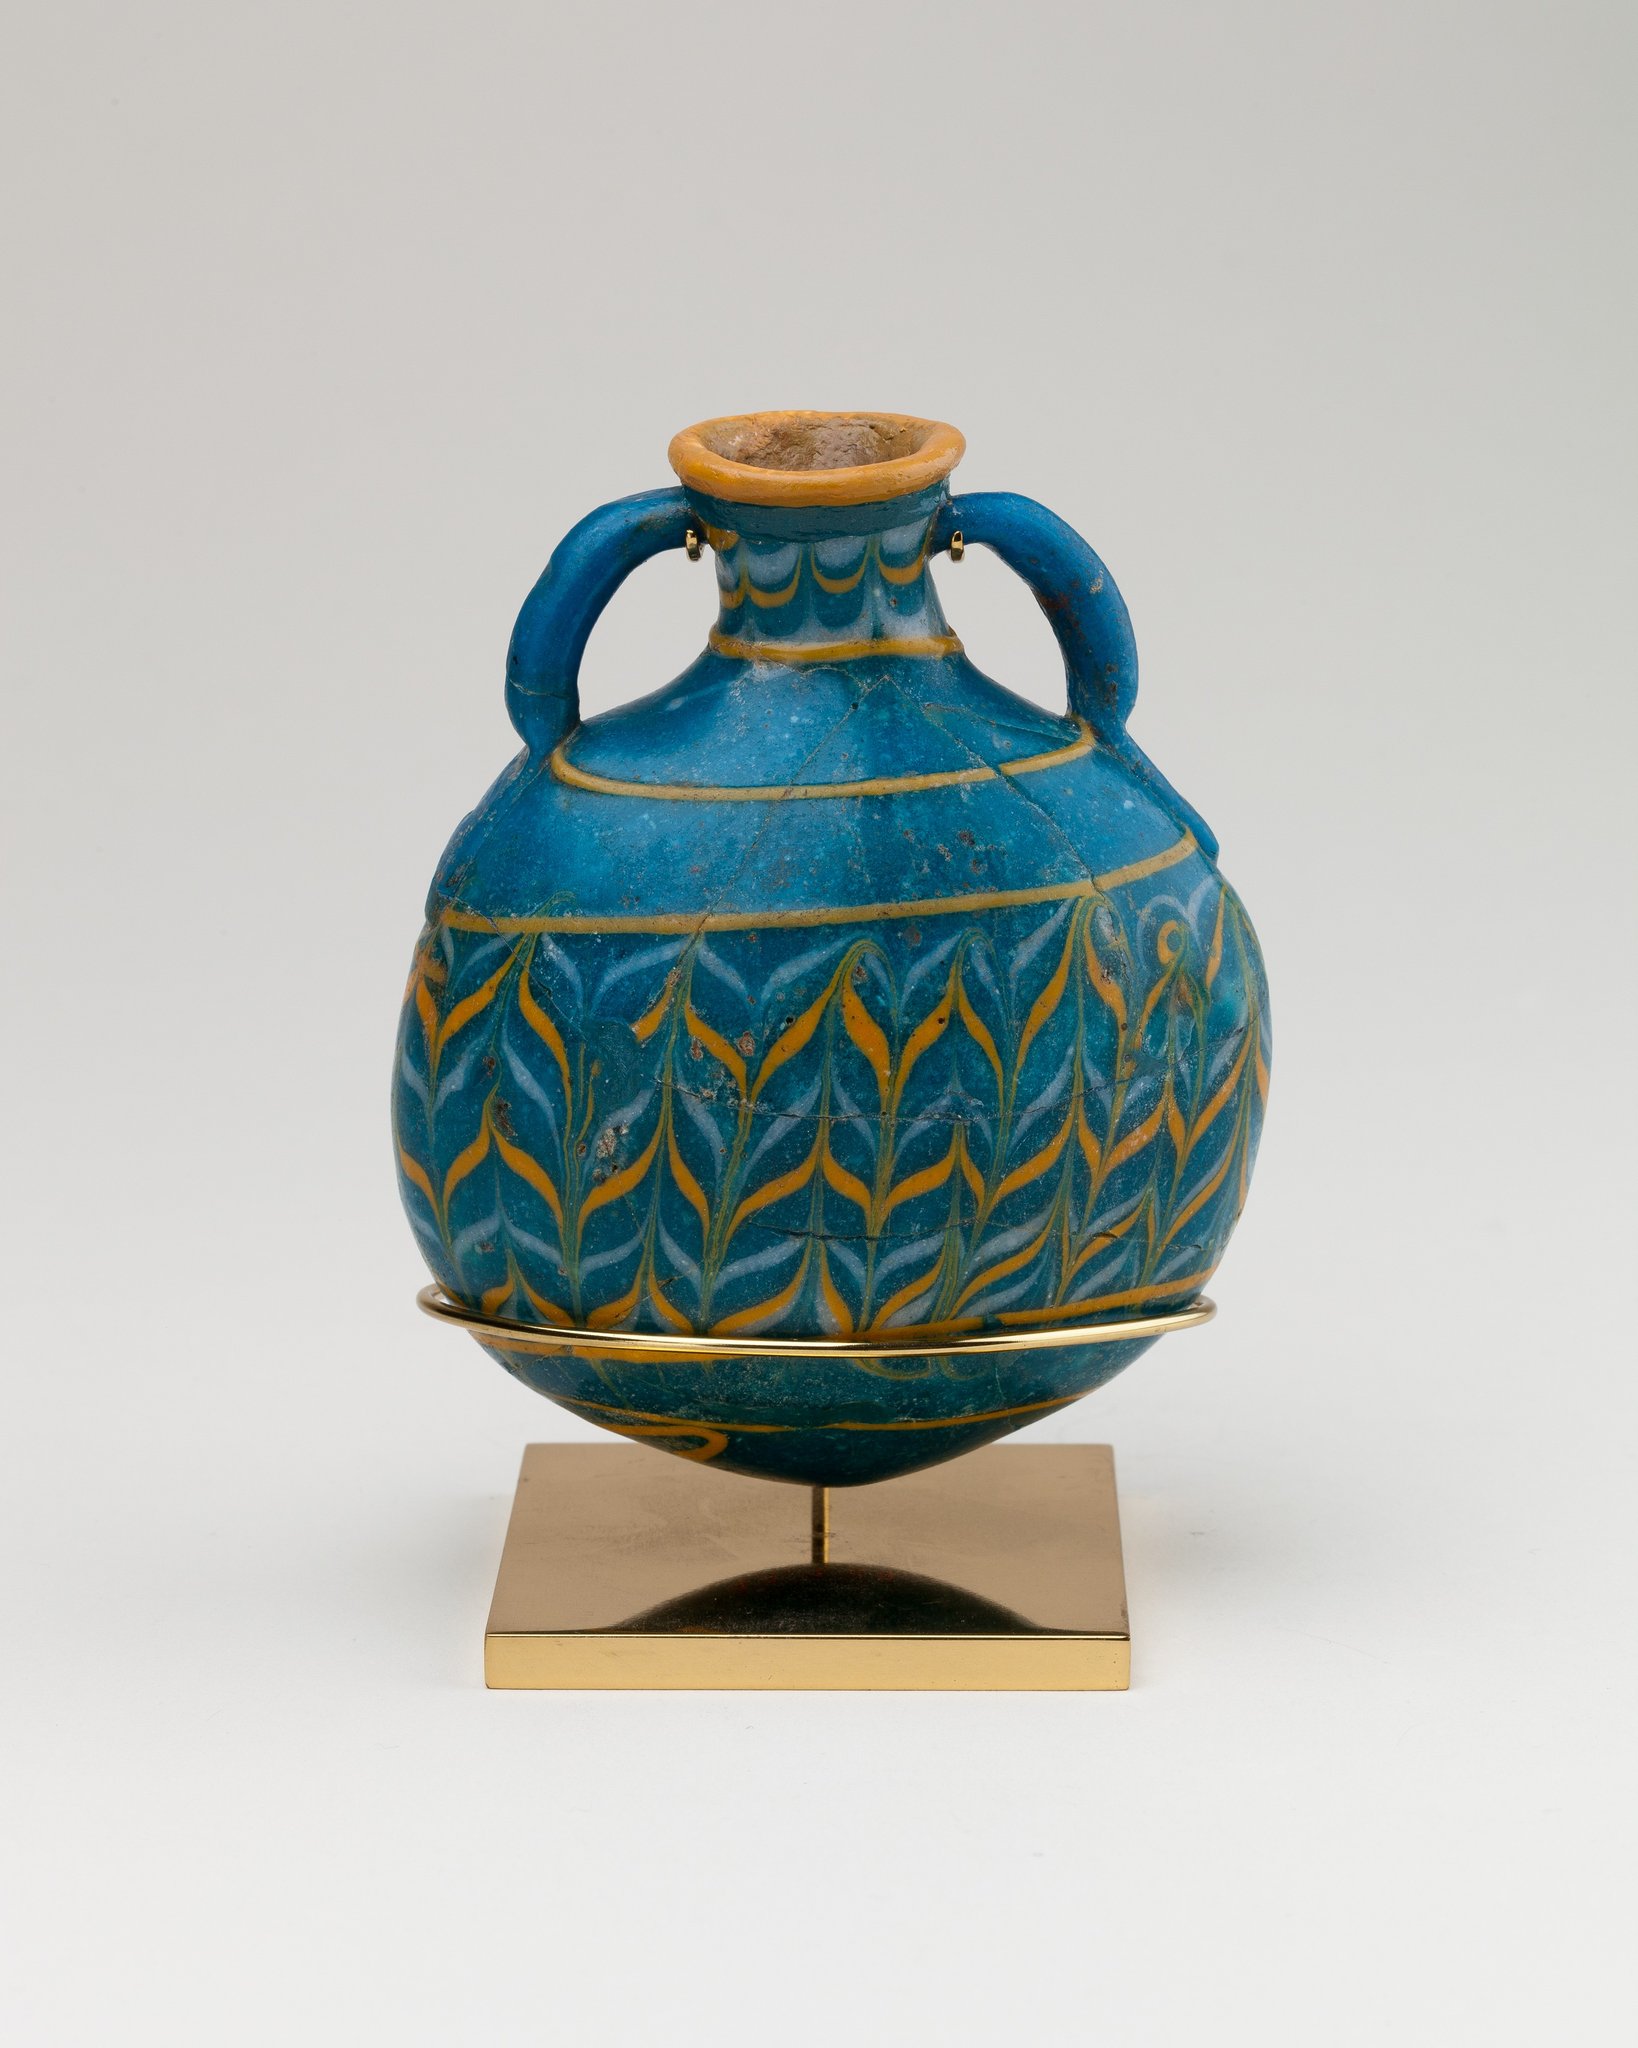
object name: bottle, lentoid amphora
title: Bottle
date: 1295-1070 BCE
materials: glass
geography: egypt